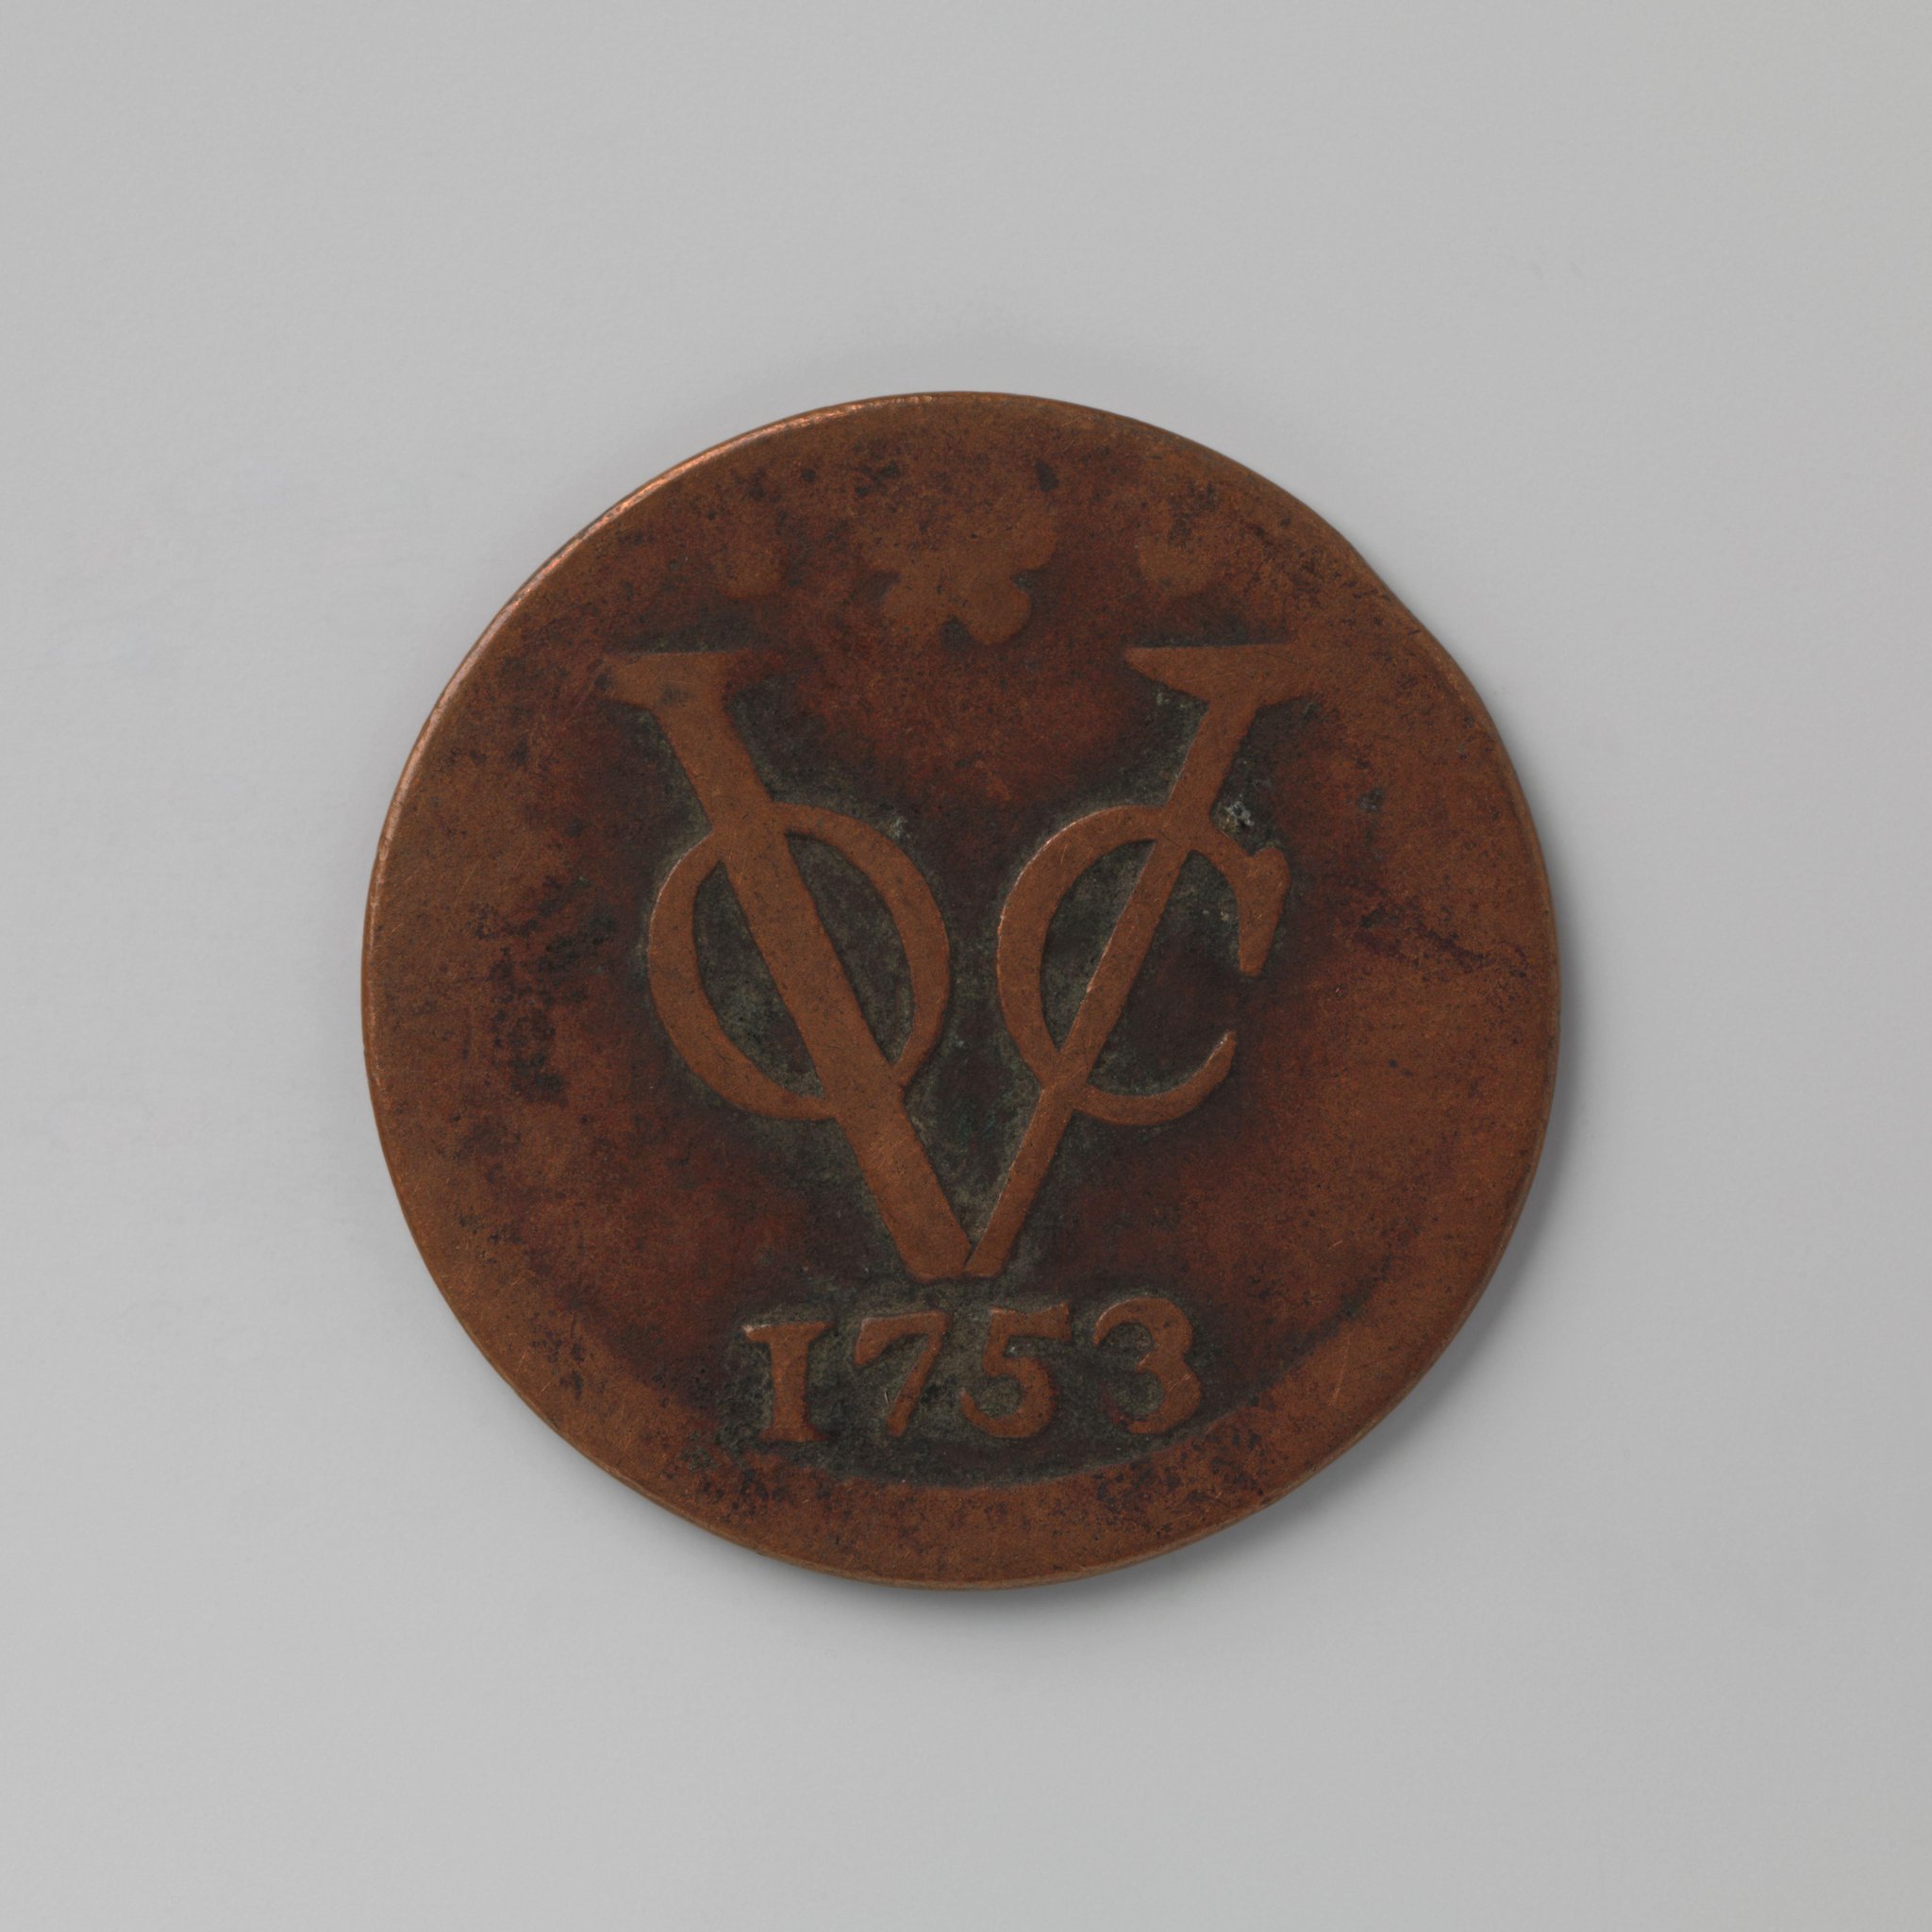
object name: coin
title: VOC, duit Holland, 1753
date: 1753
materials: copper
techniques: striking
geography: dordrecht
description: Koperen munt. Voorzijde: gekroond wapenschild van Holland. Keerzijde: monogram van de VOC, waarboven muntteken en waaronder jaartal. Gladde rand.